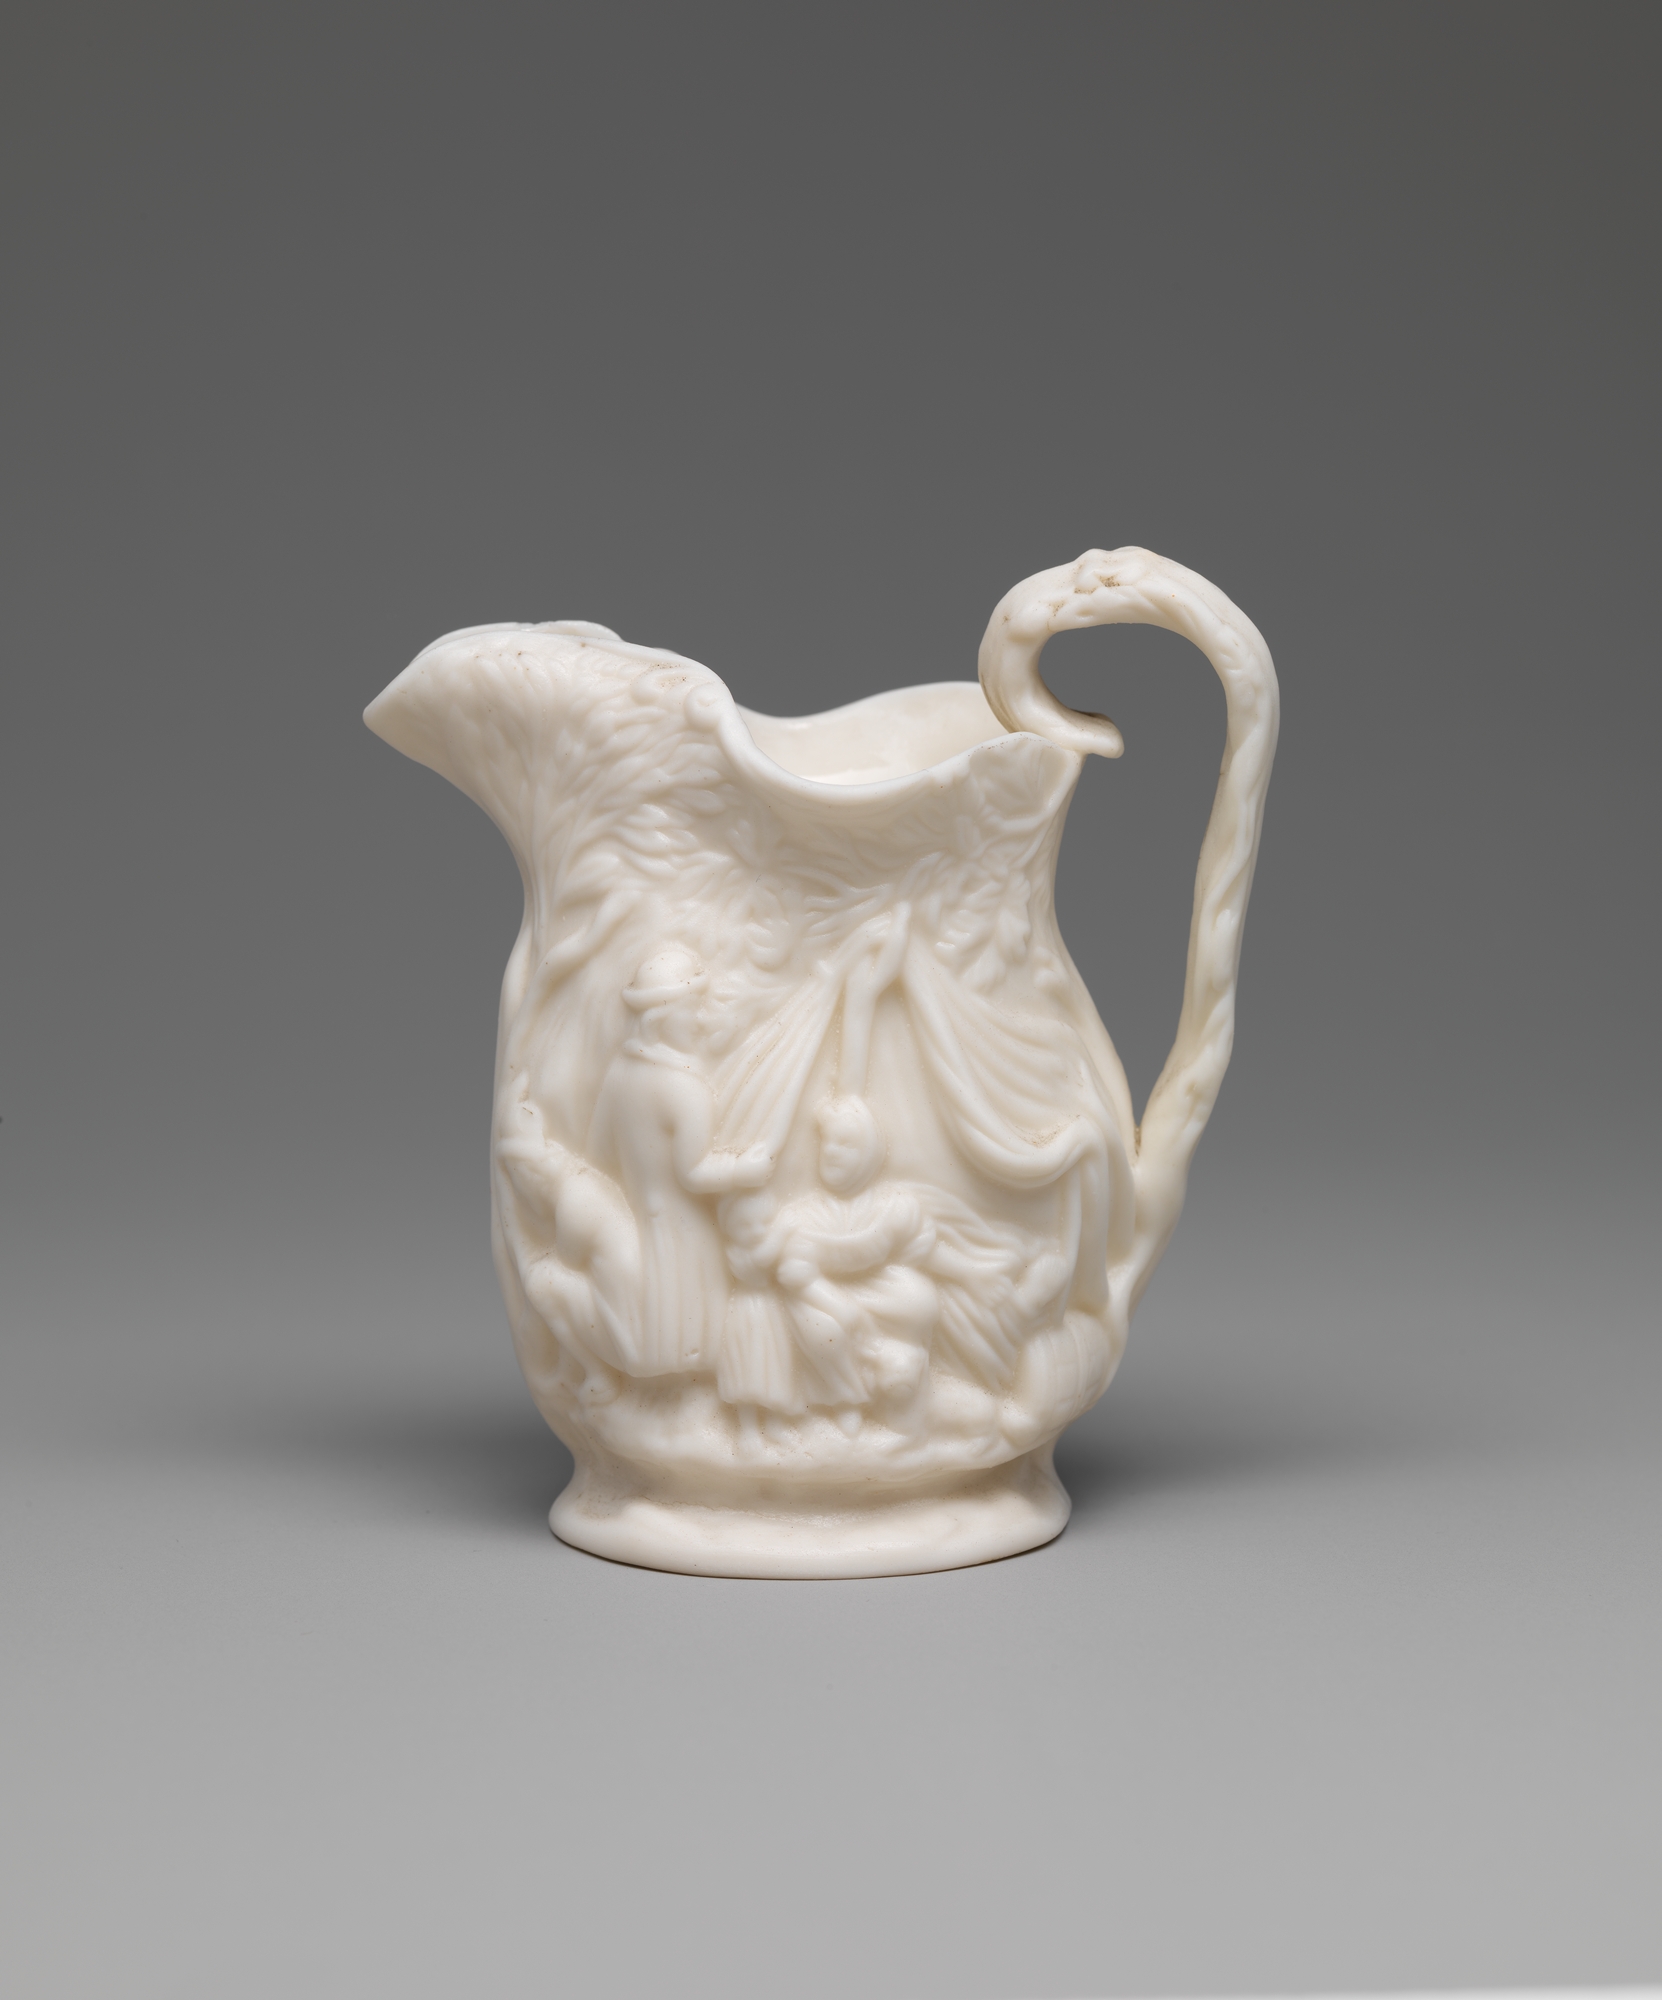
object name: pitcher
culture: american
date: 1830-1870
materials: porcelain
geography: united states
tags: men,women